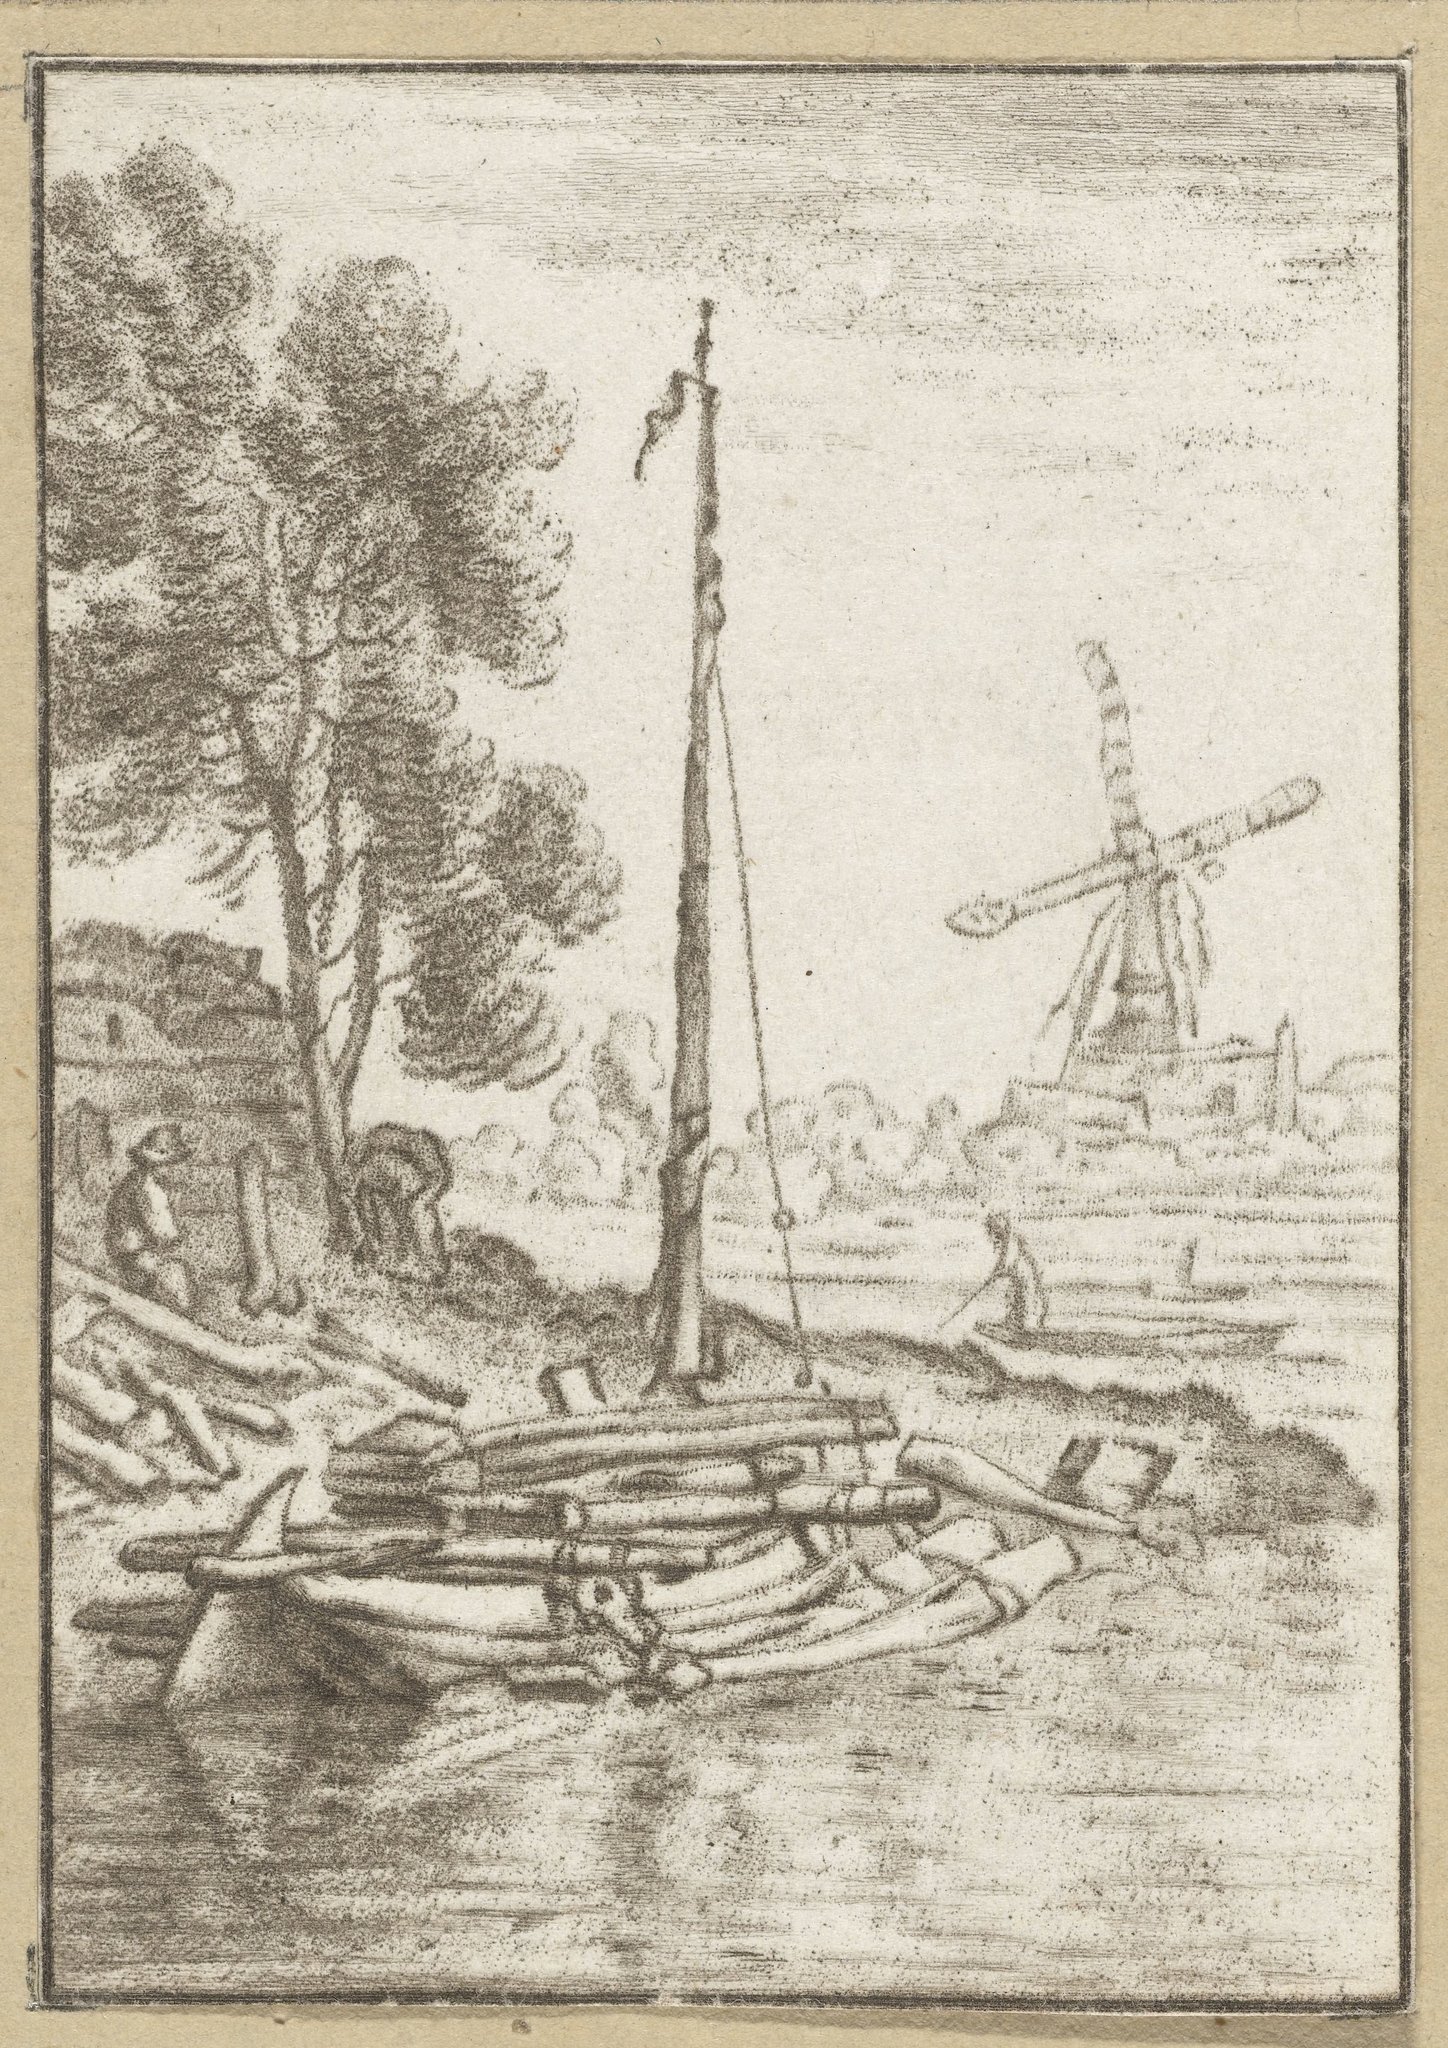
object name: print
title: Prentwerk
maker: cornelis ploos van amstel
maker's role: draughtsman, print maker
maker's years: 1726-1798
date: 1761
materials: paper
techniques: printmaking, etching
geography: amsterdam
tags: river, shipyard, shipdock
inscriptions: collector's mark: Lugt 2725, collector's mark: Lugt 12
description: De bocht van een rivier met links een scheepswerf en aan de overzijde een molen.